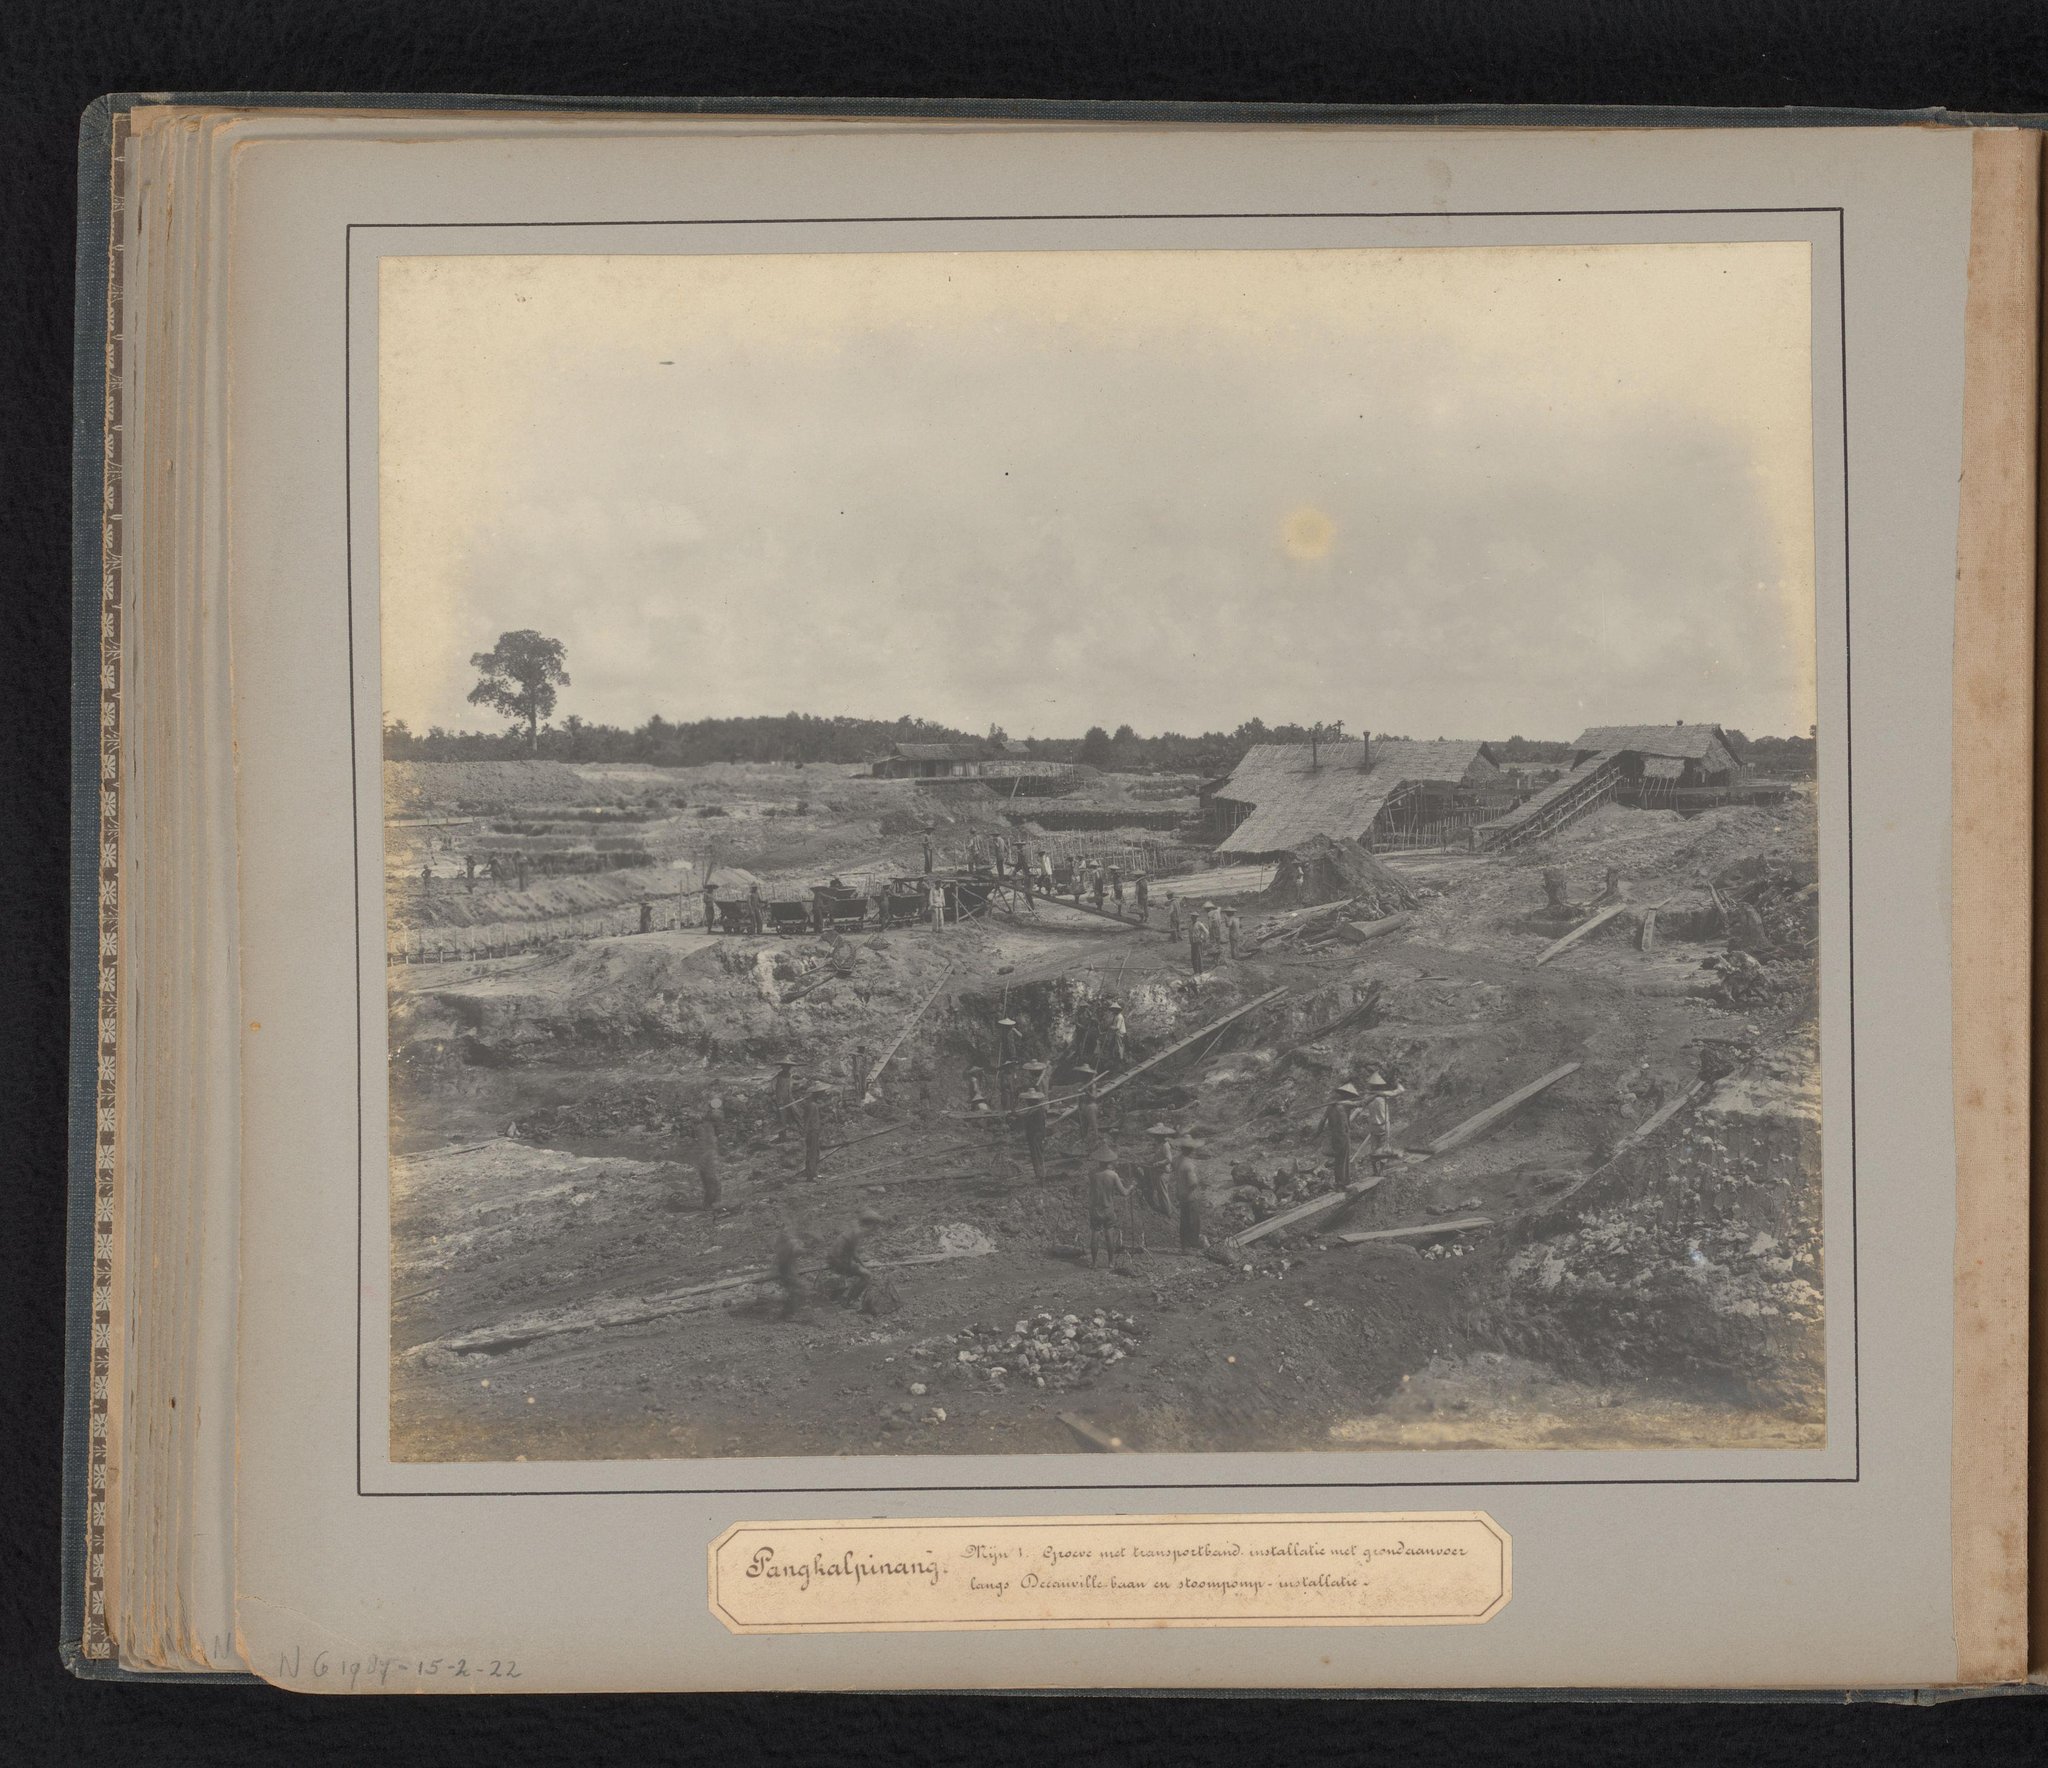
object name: photograph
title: Pangkalpinang. Mijn 1. Groeve met transportband installatie met grondaanvoer langs Decauville-baan en stoompomp-installatie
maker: Anonymous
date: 1907-1919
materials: cardboard, photographic support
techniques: gelatin silver print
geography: bangka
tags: robert julius boers, colonial system, opencast mine; strip mining, minerals and metals: tin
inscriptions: label: ‘Pangkalpinang. Mijn 1. Groeve met transportband installatie met grondaanvoer langs Decauville-baan en stoompomp-installatie’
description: De groeve van een open tinmijn van de Banka-tinwinning te Pangkalpinang met Chinese mijnwerkers en gemechaniseerde afvoer van tinerts in karretjes getrokken door een stoomlier. Onderdeel van het fotoalbum over de Banka-tinwinning, ca. 1907-1919.